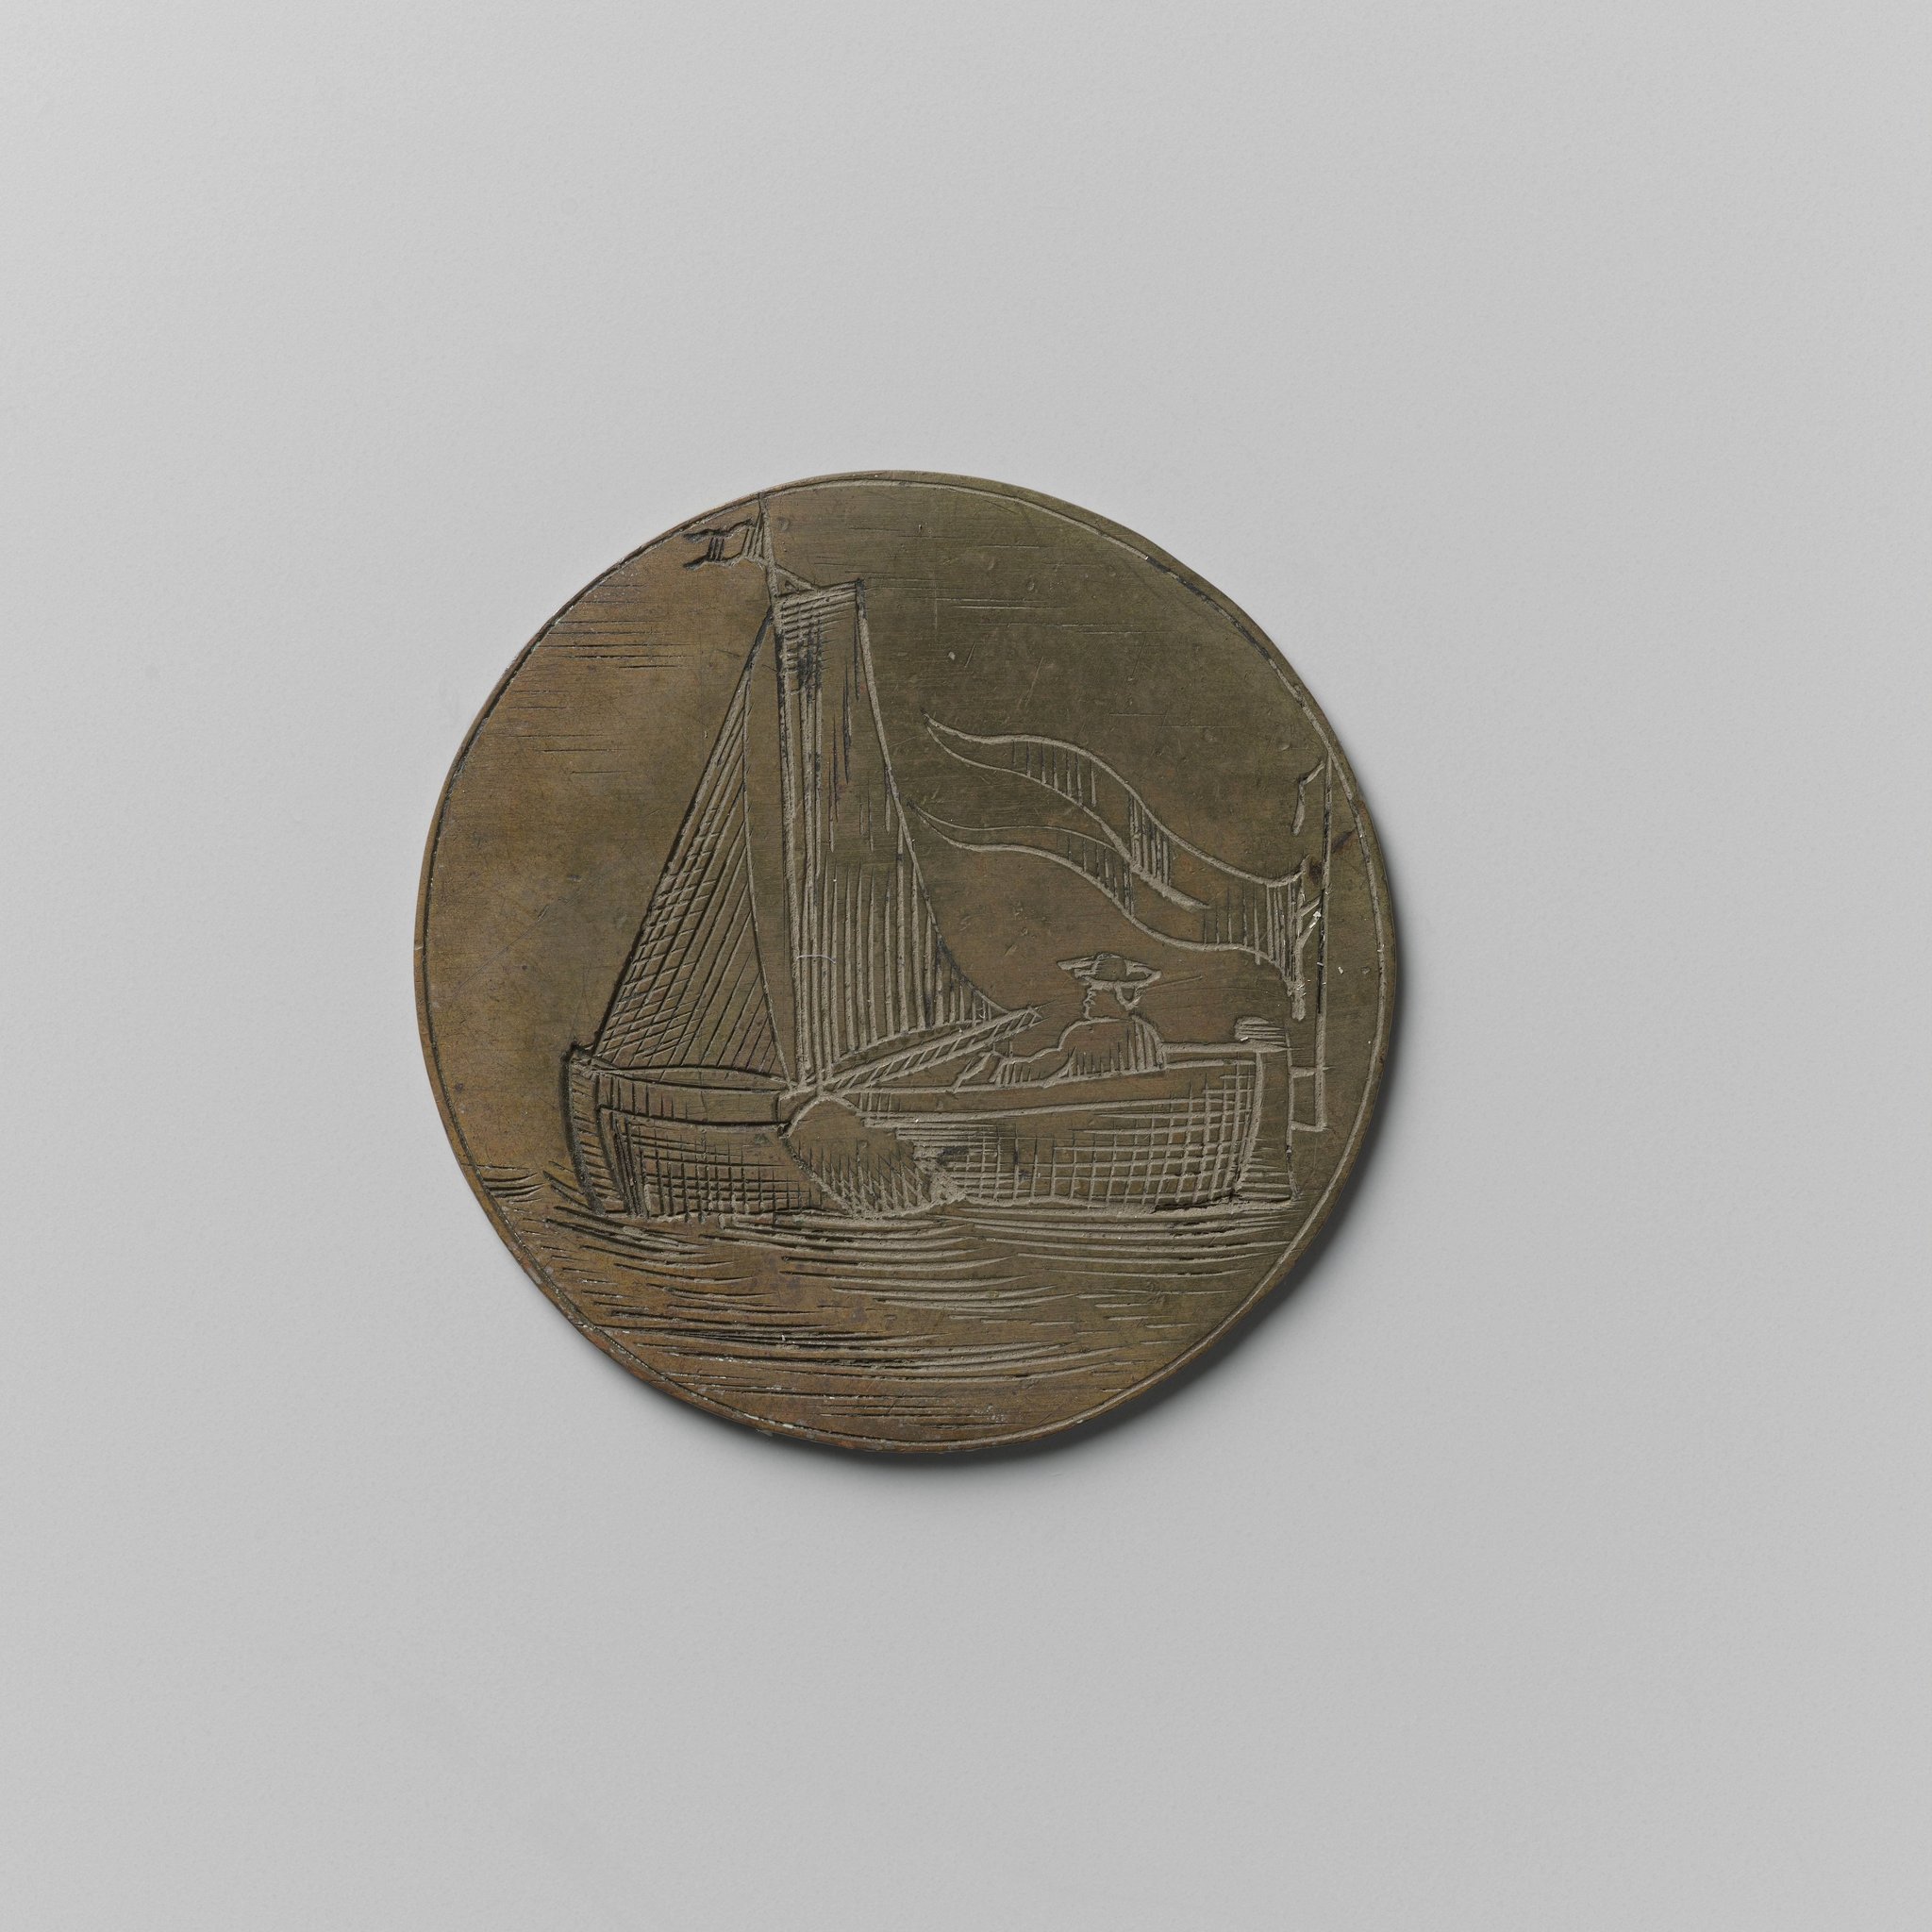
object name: medal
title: Roei-, steiger- en schuitenvoerdersgilde van Amsterdam, gildepenning van Dirk Coersen Dirksz, ligplaats Kamper steiger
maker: Anonymous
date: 1776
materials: brass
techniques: engraving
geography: amsterdam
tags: amsterdam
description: Messing penning. Voorzijde: naar links varende zeilboot; op achterplecht: zittende man en vlag. Keerzijde: opschrift boven huismerk en hart met daarin letters D, C, D en Z tussen monogram van letters K en S